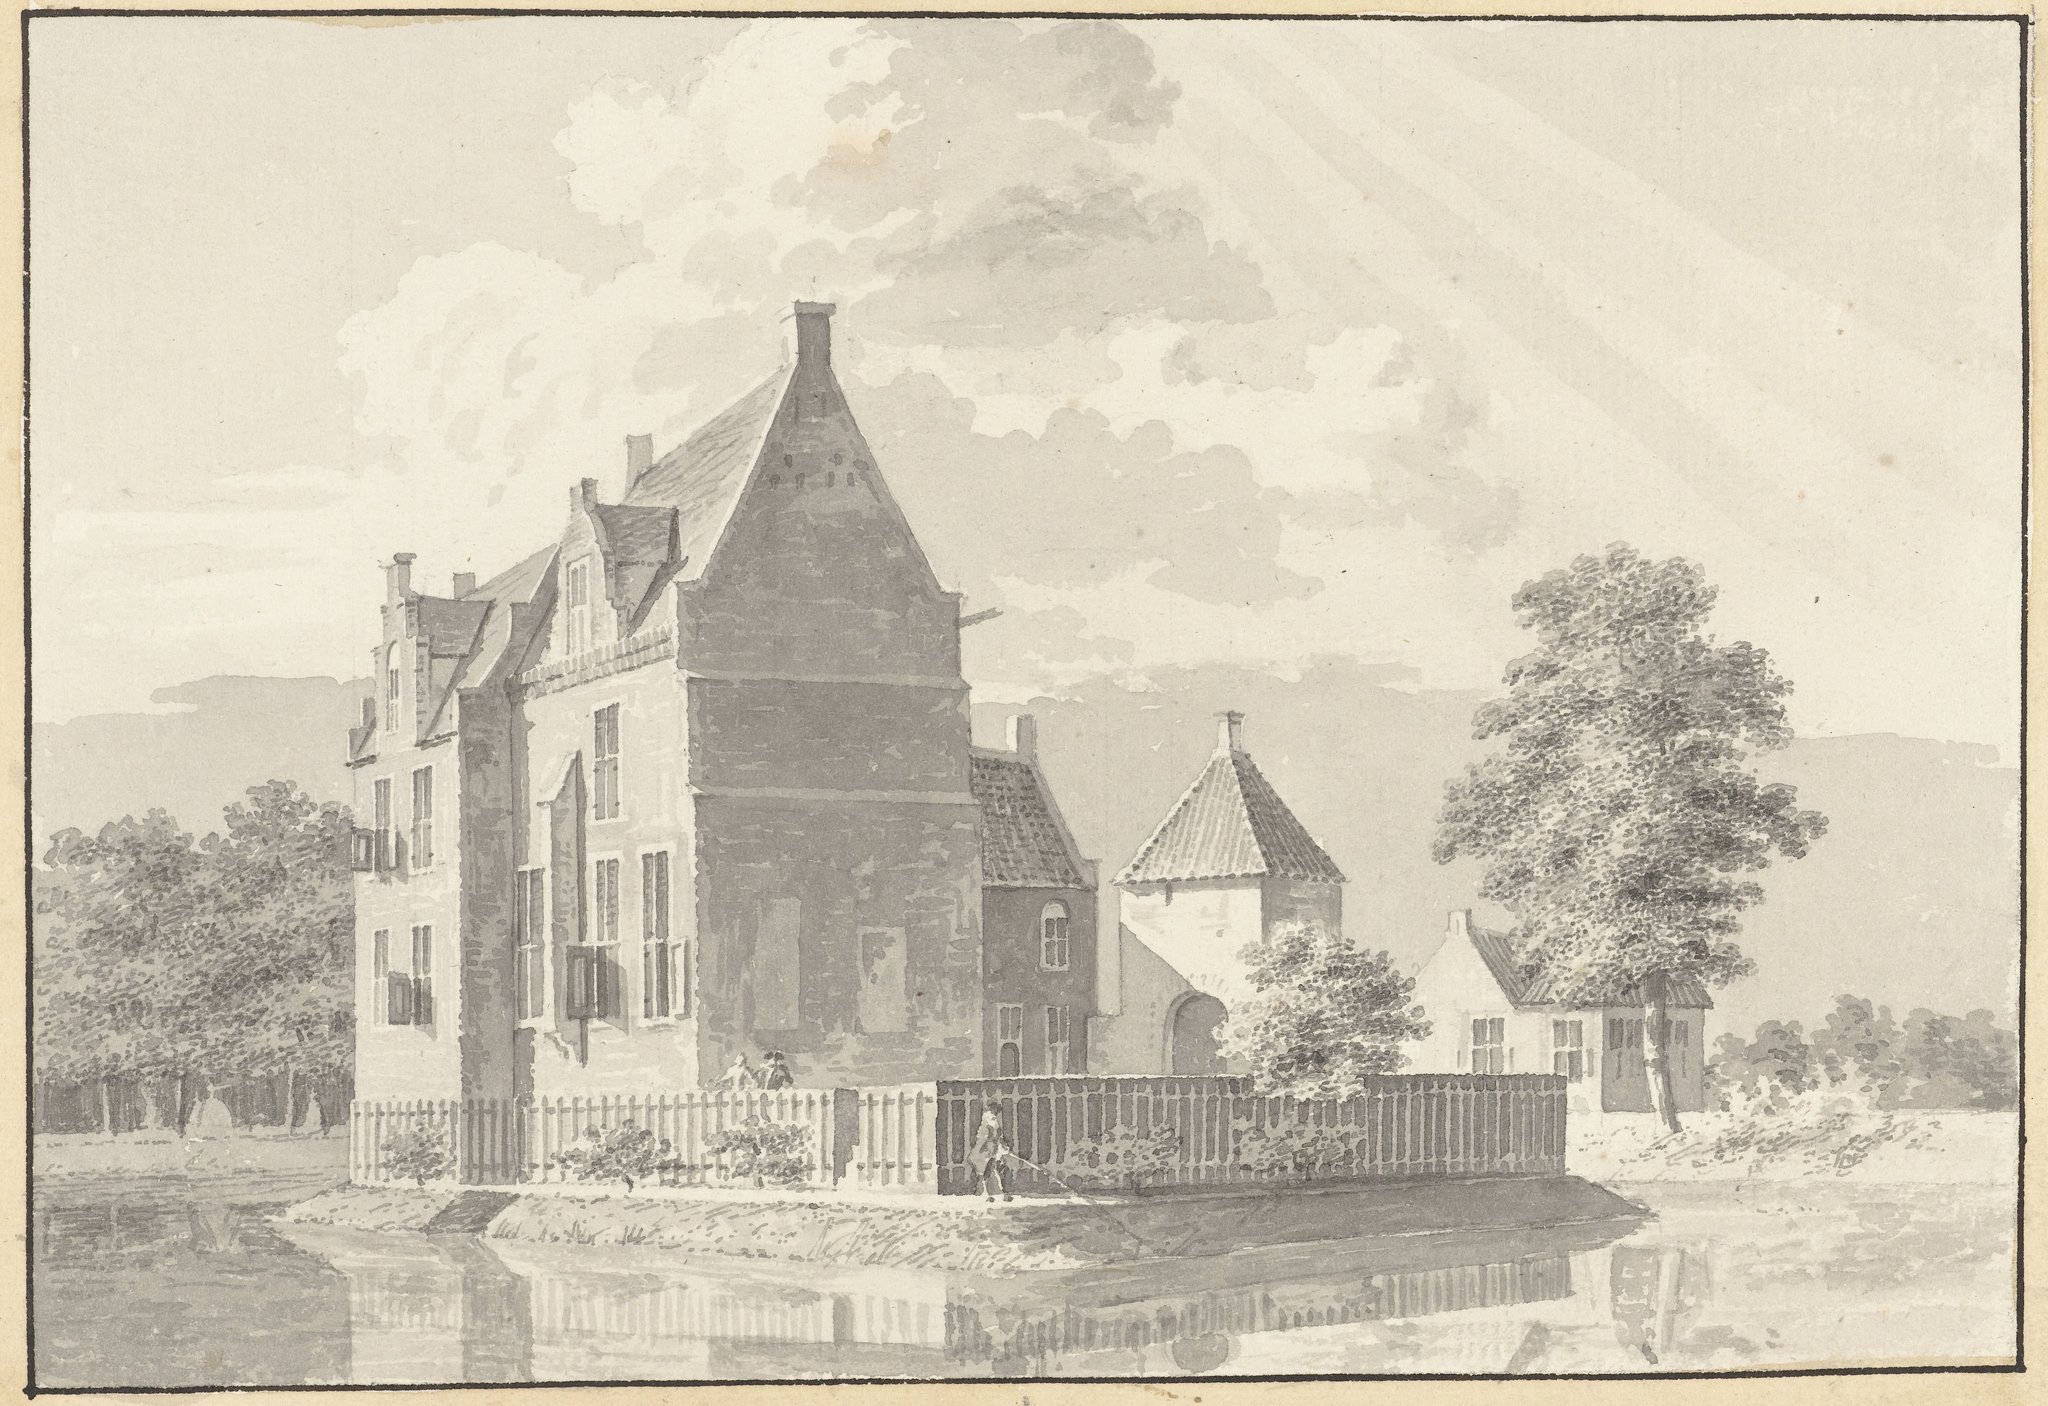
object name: drawing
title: Kasteel Rhijnauwen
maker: cornelis pronk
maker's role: draughtsman, painter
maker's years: 1691-1759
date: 1701-1759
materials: ink, paper, pencil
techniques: brush, pen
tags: castle